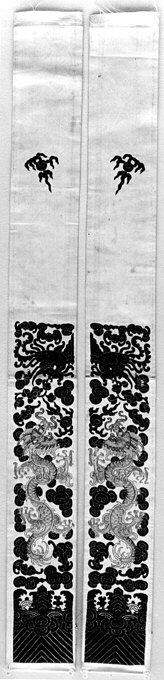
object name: sleeve band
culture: chinese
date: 1801-1900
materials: metal thread, silk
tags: dragons